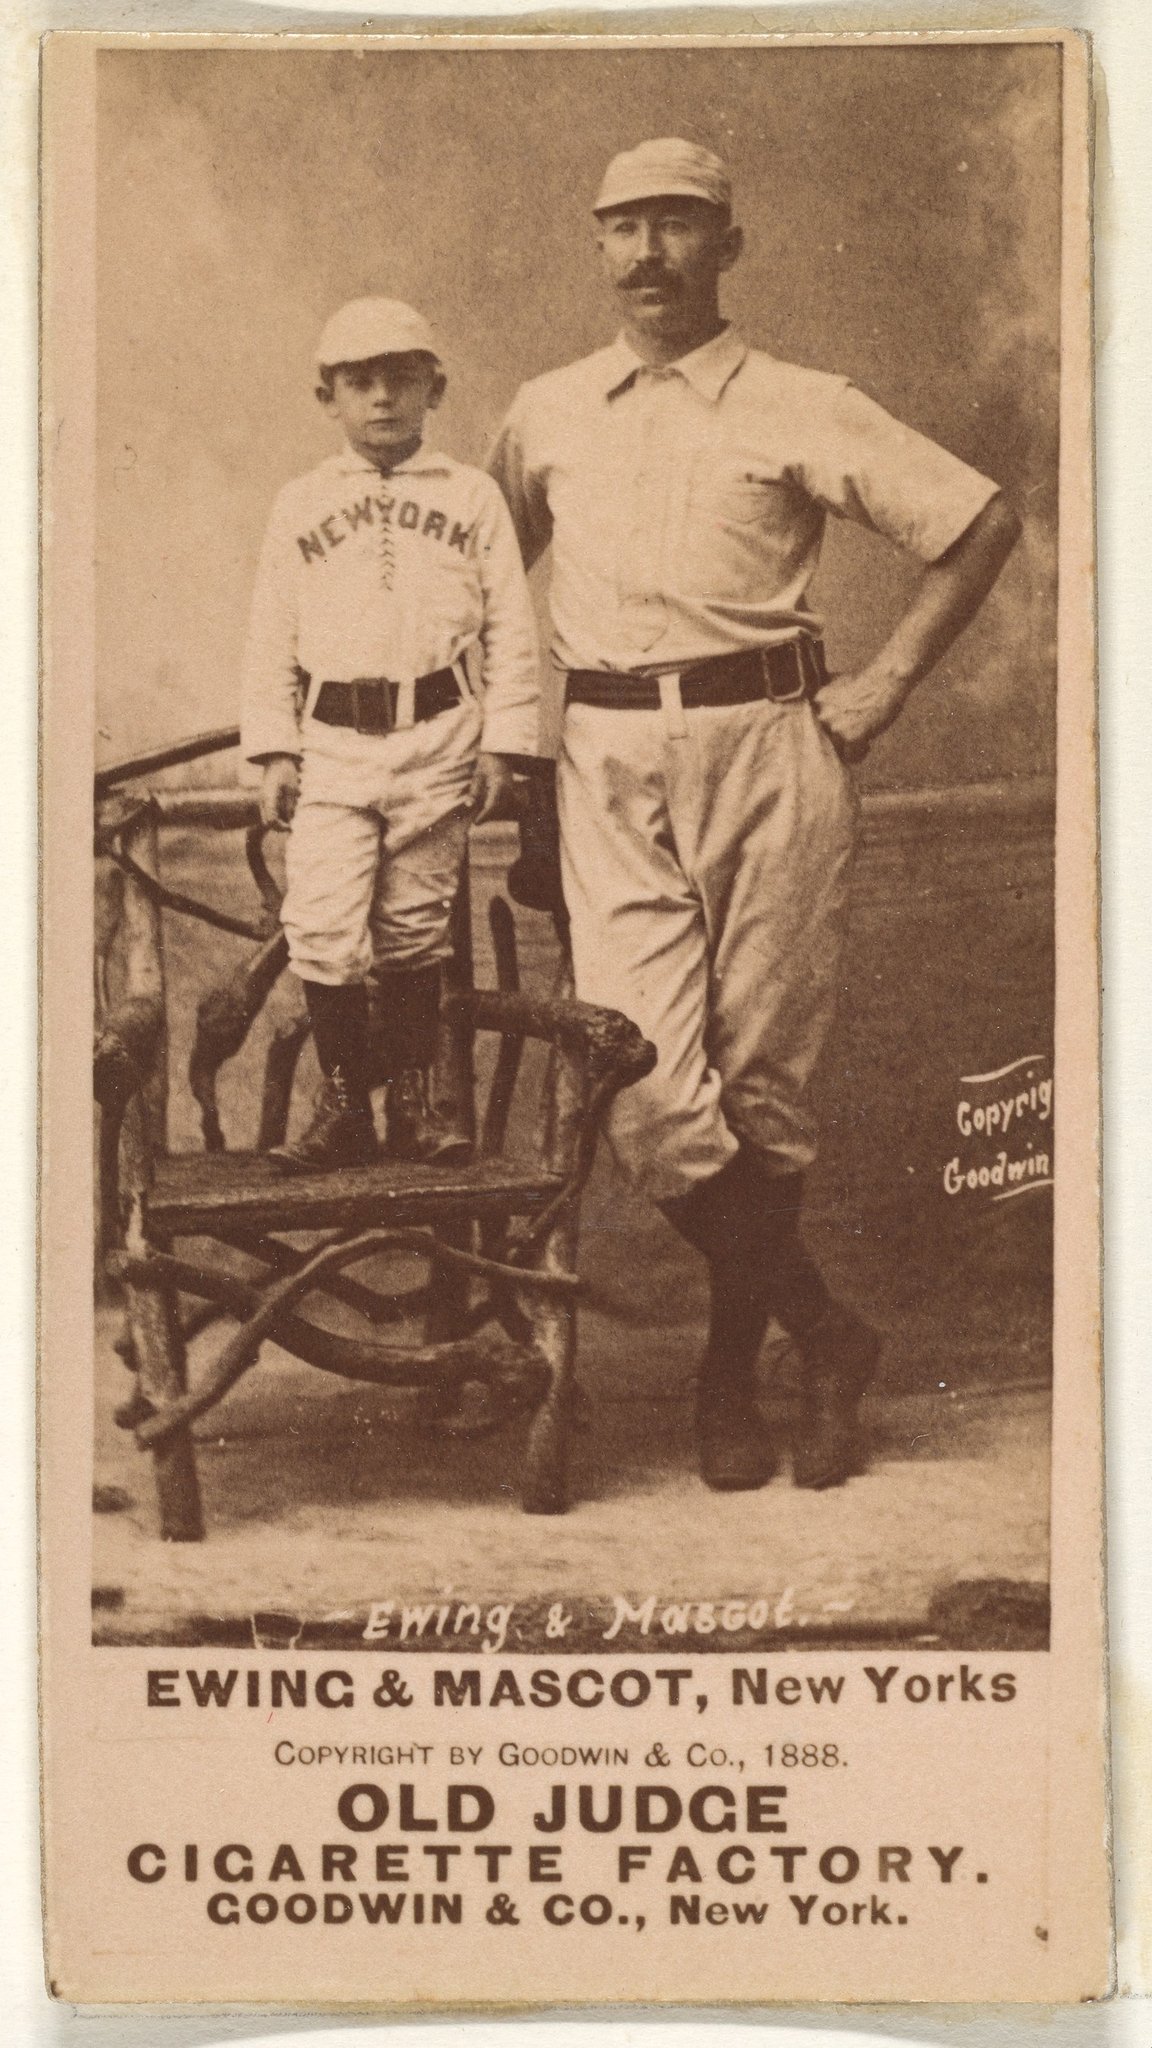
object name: baseball card, photograph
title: William "Buck" Ewing, Captain and Catcher, with Mascot, New York, from the Old Judge series (N172) for Old Judge Cigarettes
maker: goodwin & company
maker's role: publisher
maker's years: 1850-1950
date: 1888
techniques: albumen silver print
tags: boys,men,portraits,baseball,athletes,chairs